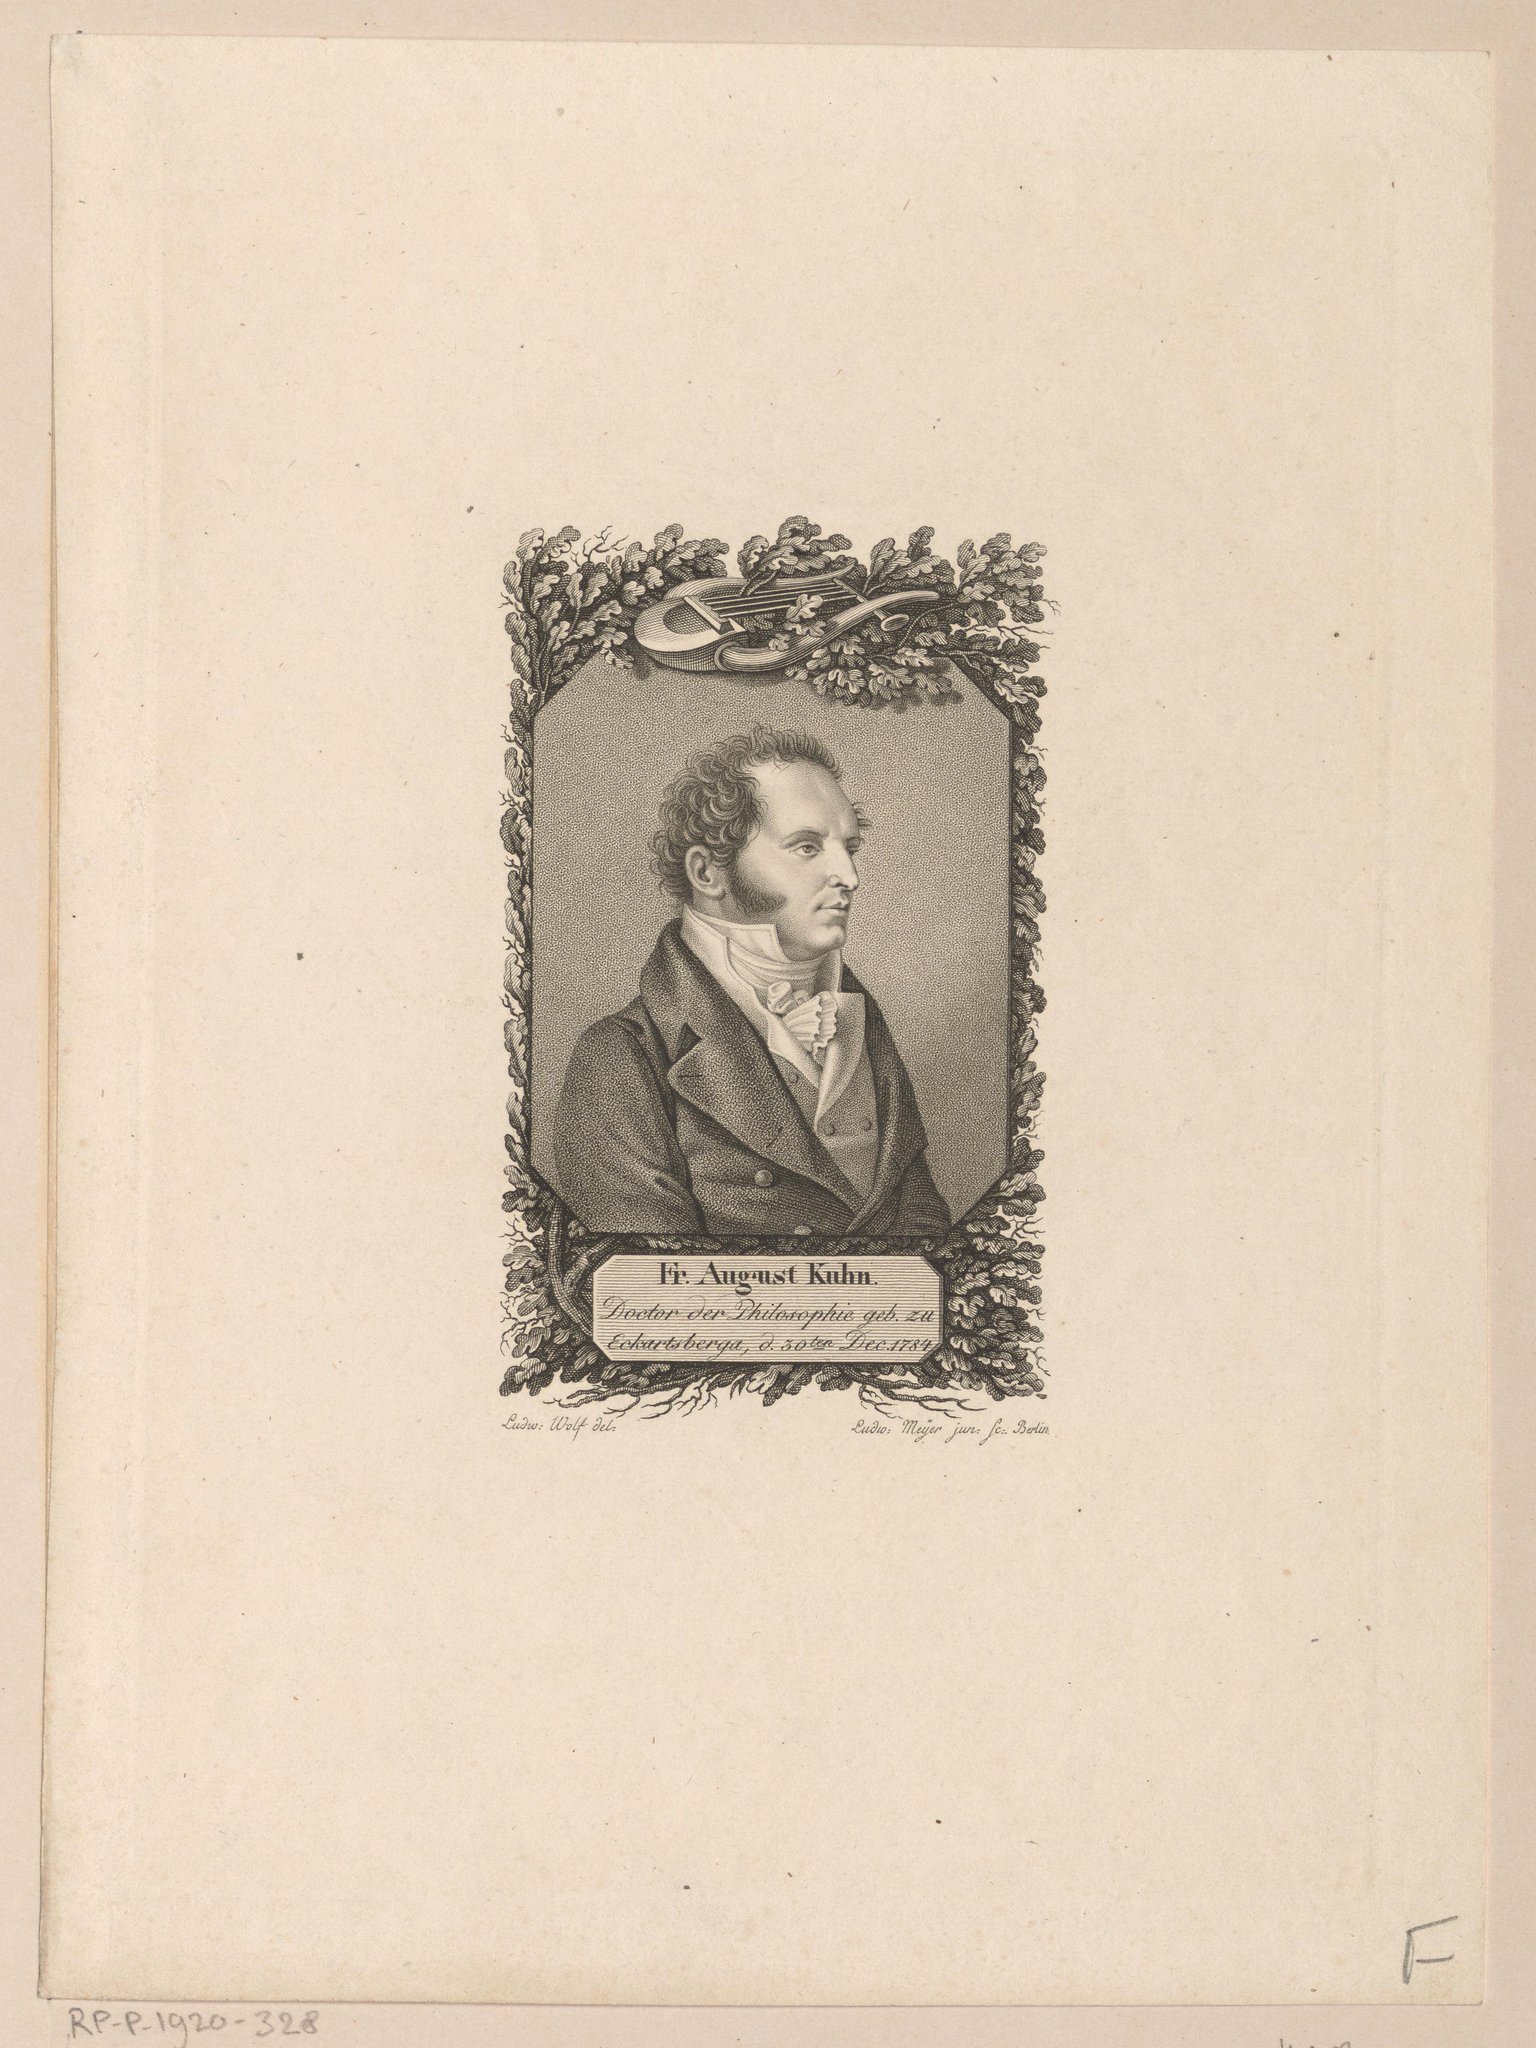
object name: print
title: Portret van Friedrich August Kuhn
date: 1784-1843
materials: paper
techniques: engraving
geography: berlin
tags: berlin, publisher, historical persons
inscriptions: collector's mark: Lugt 2228